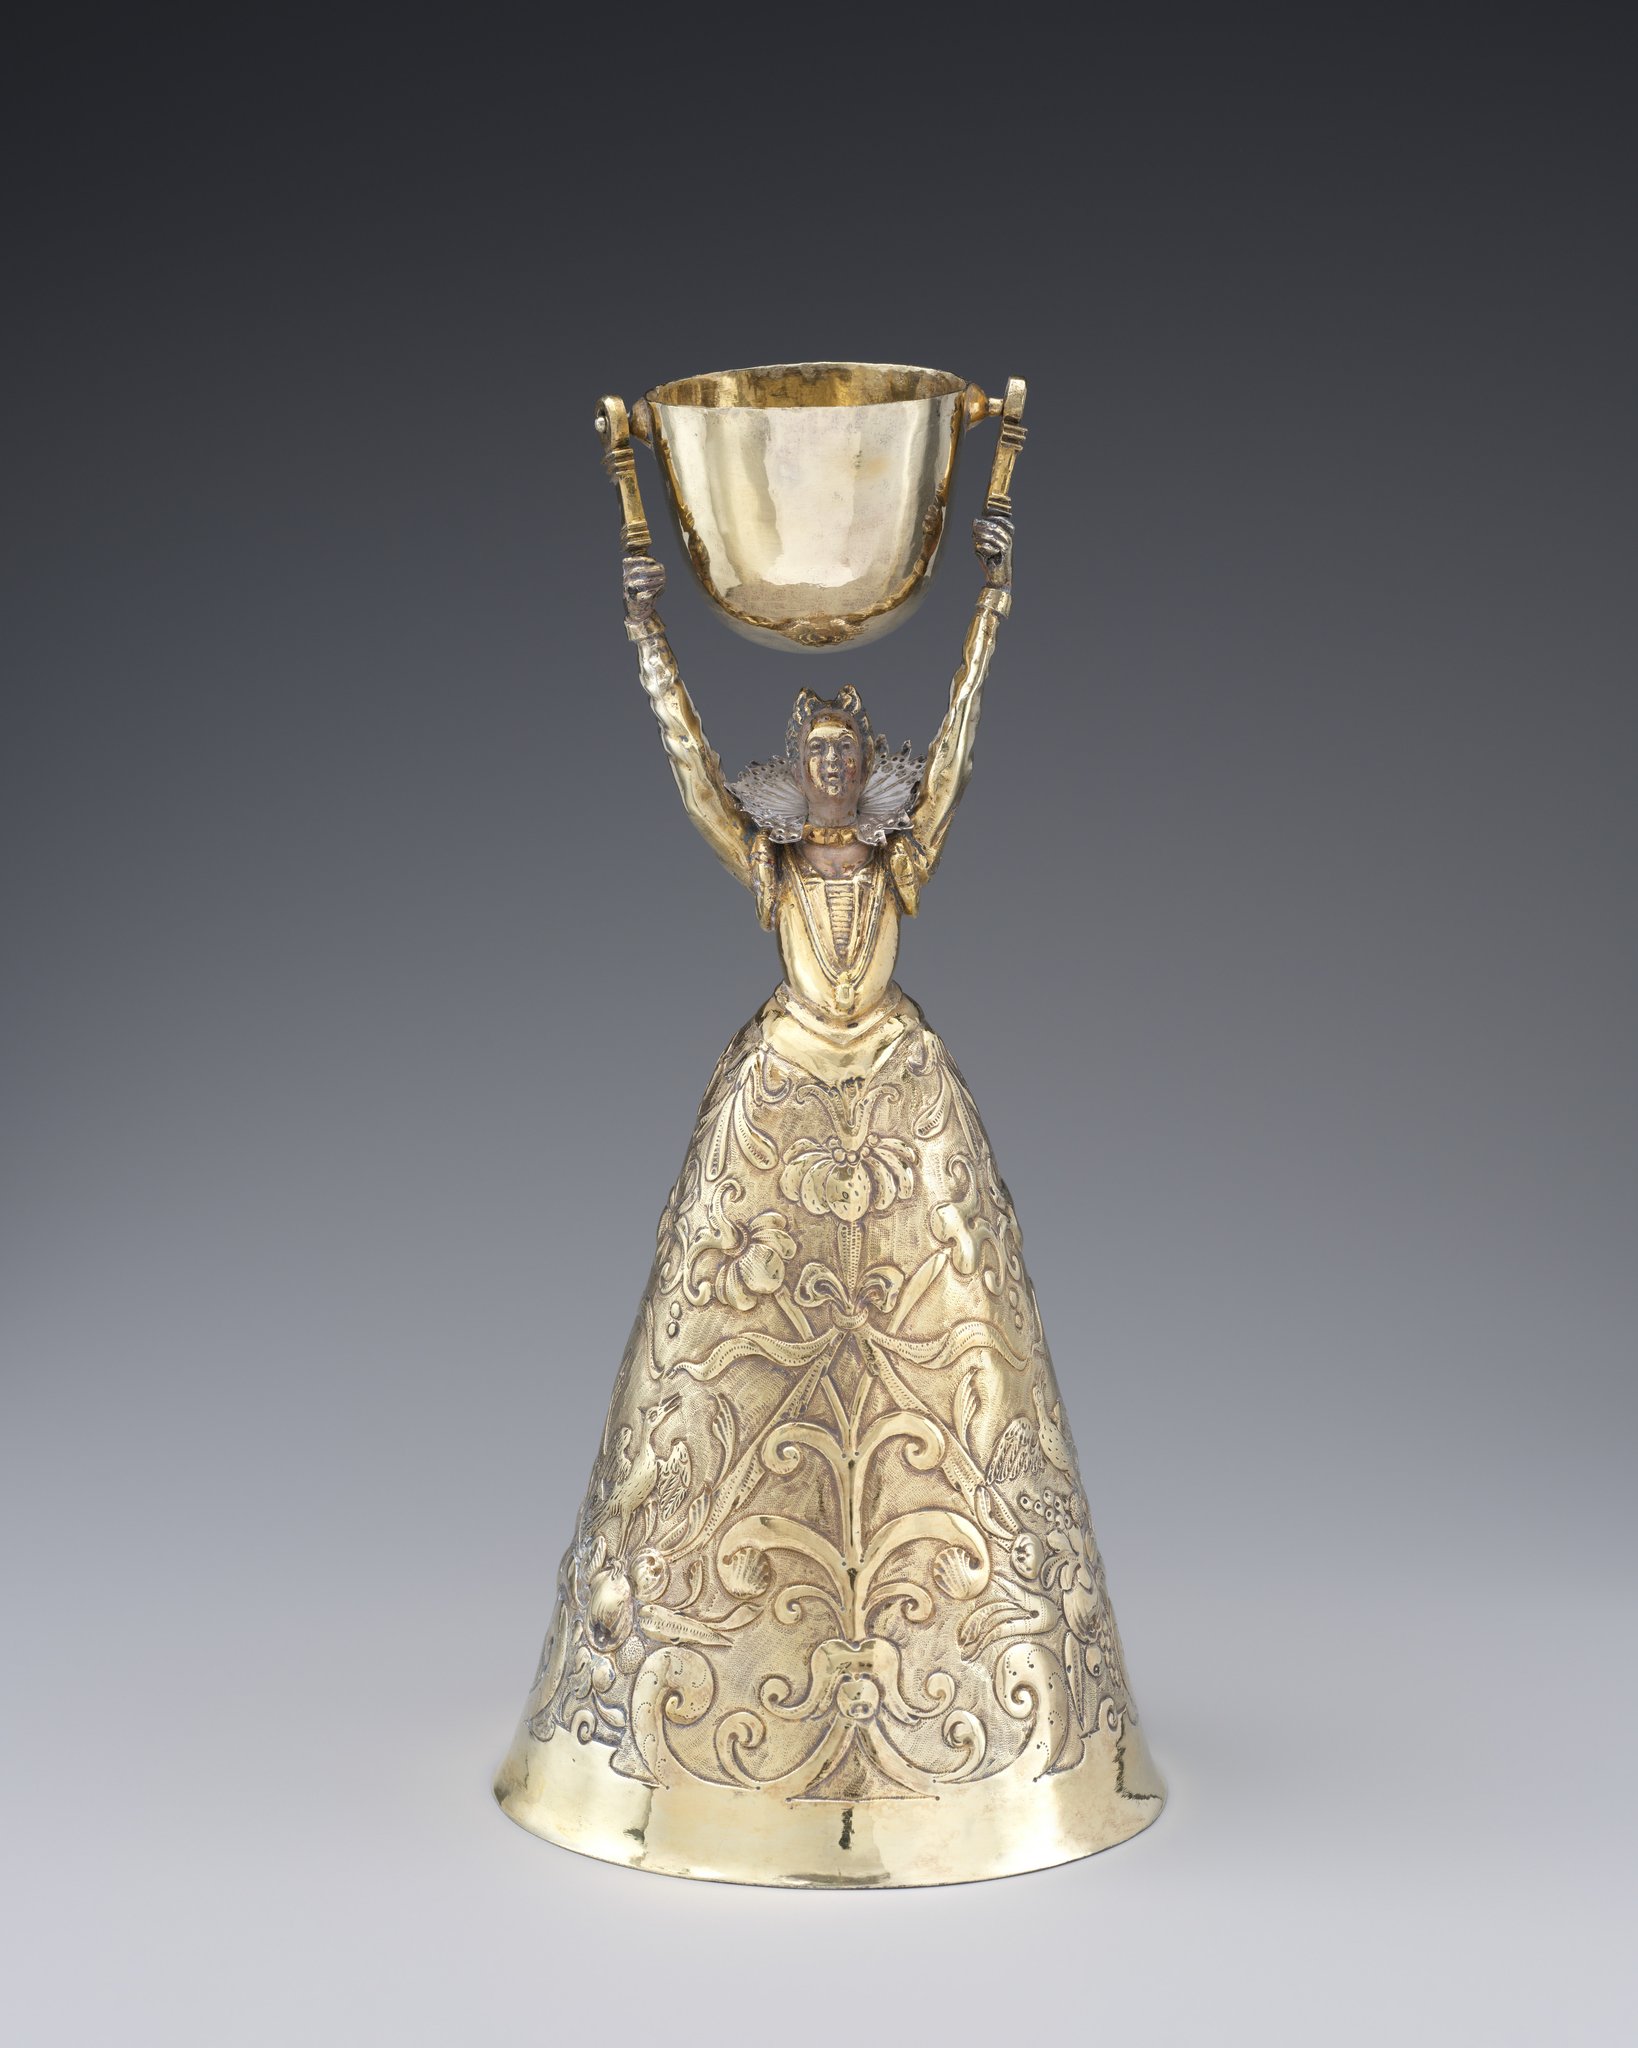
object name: wager cup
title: Wager cup (Jungfrauenbecher)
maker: hieronymus imhof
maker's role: maker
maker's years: 1535-1635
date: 1620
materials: enamel, gilt, silver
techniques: painting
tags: women